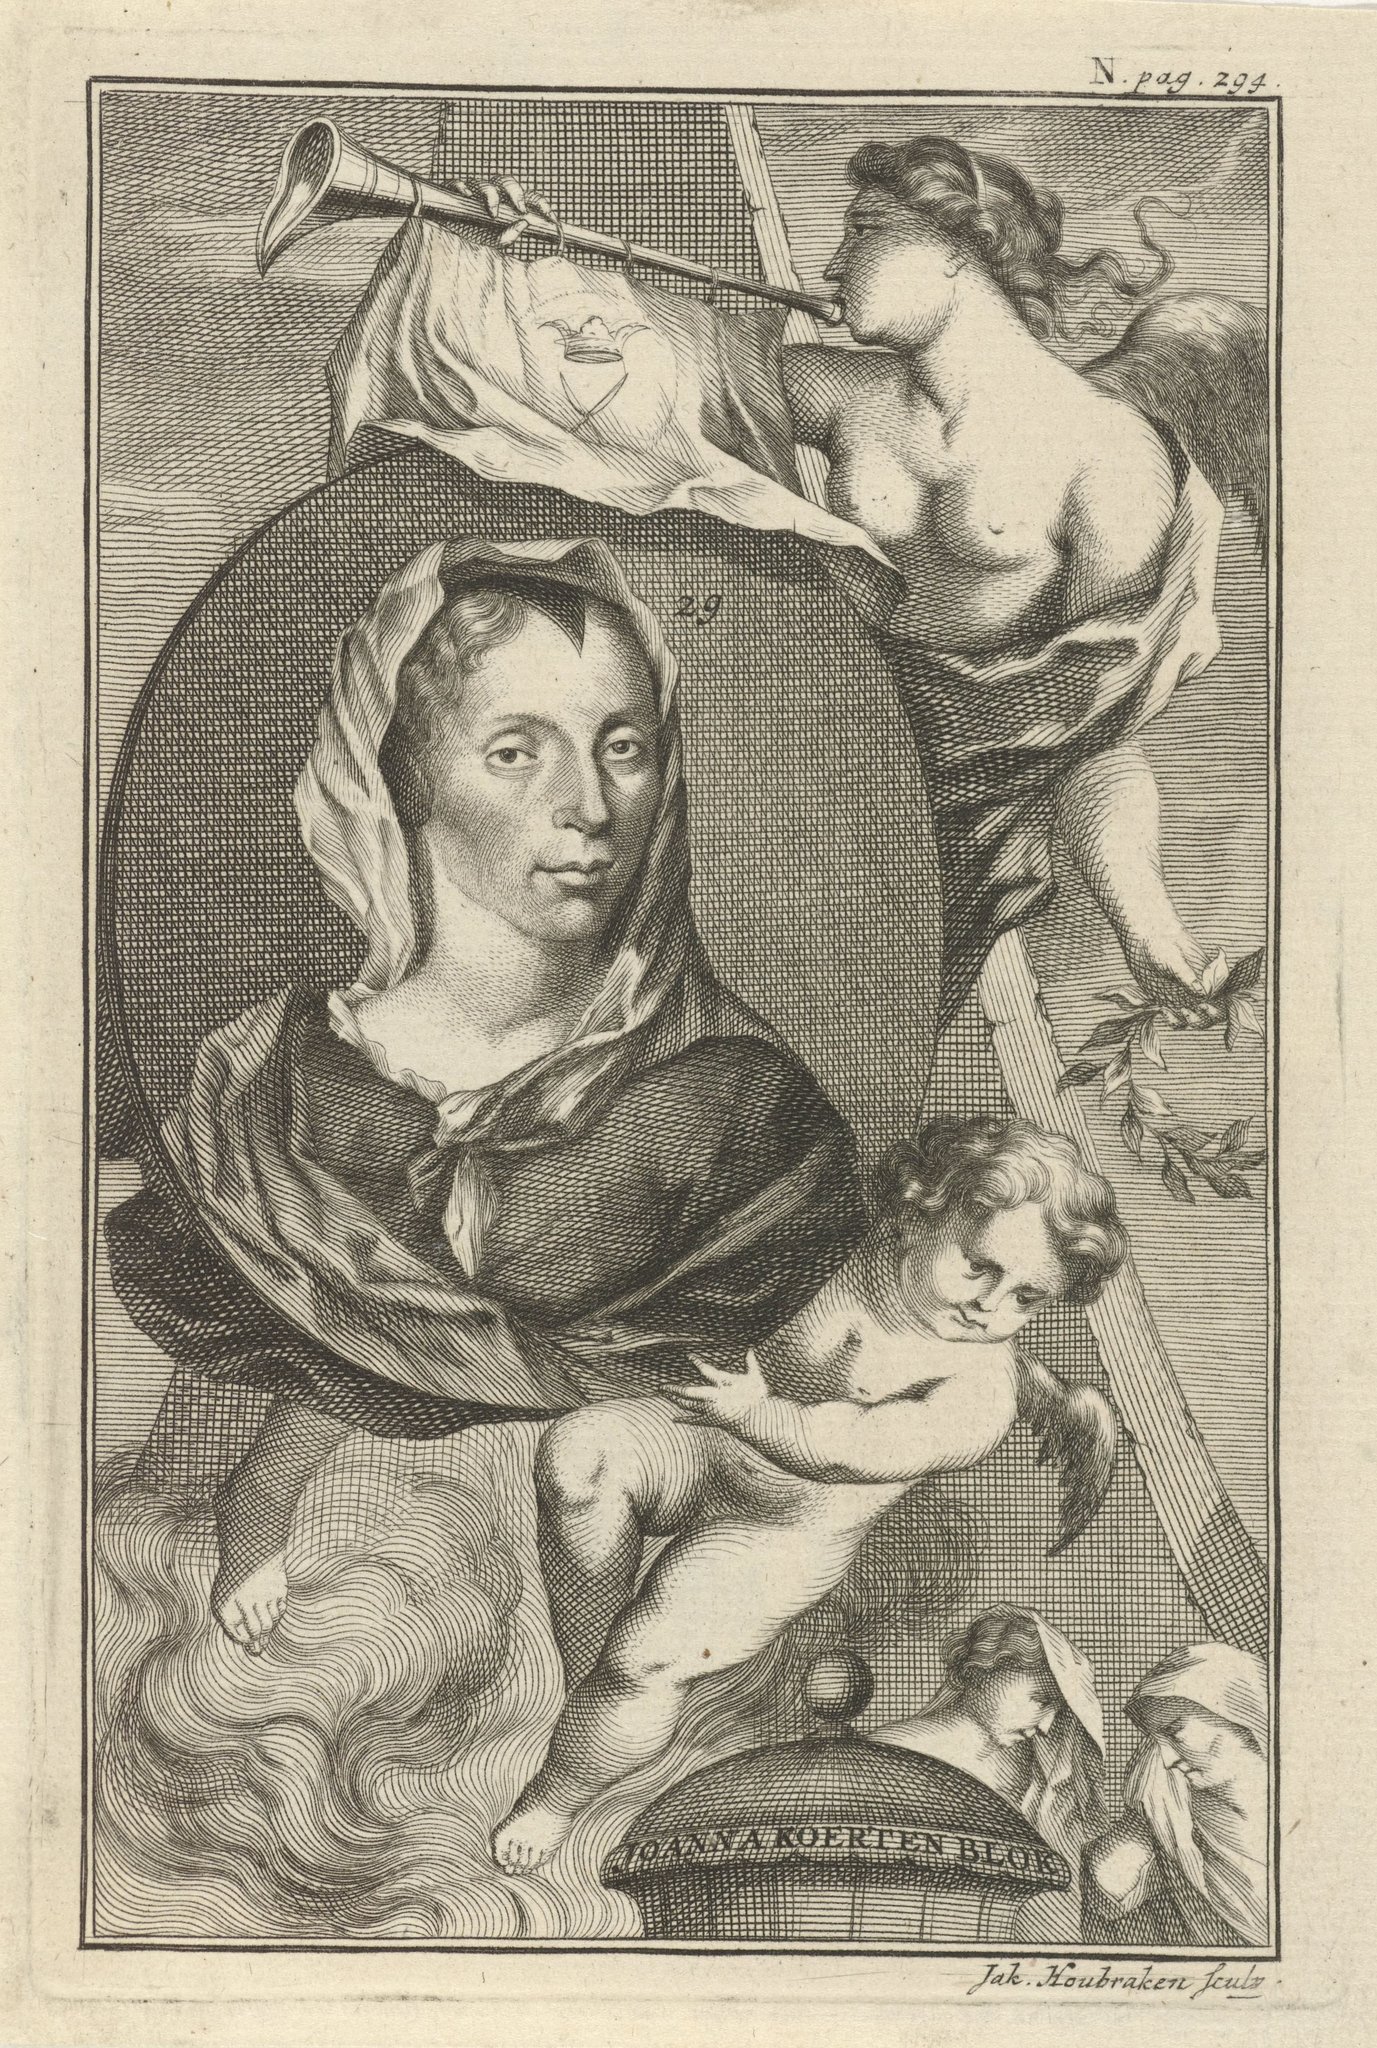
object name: book illustration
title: Portret van Johanna Koerten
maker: jacob houbraken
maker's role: draughtsman, print maker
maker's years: 1698-1780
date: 1721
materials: paper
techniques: engraving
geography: amsterdam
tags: draughtsman, johanna koerten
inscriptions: collector's mark: Lugt 2228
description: Prent ook gebruikt in: Arnold Houbraken. De groote Schouburgh der Nederlantsche konstschilders en schilderessen : waar van 'er vele met hunne beeltenissen ten tooneel verschynen, ... zynde een vervolg op het Schilderboek van K. van Mander. 3 dln. Eerste druk. Amsterdam: 1718-1721.